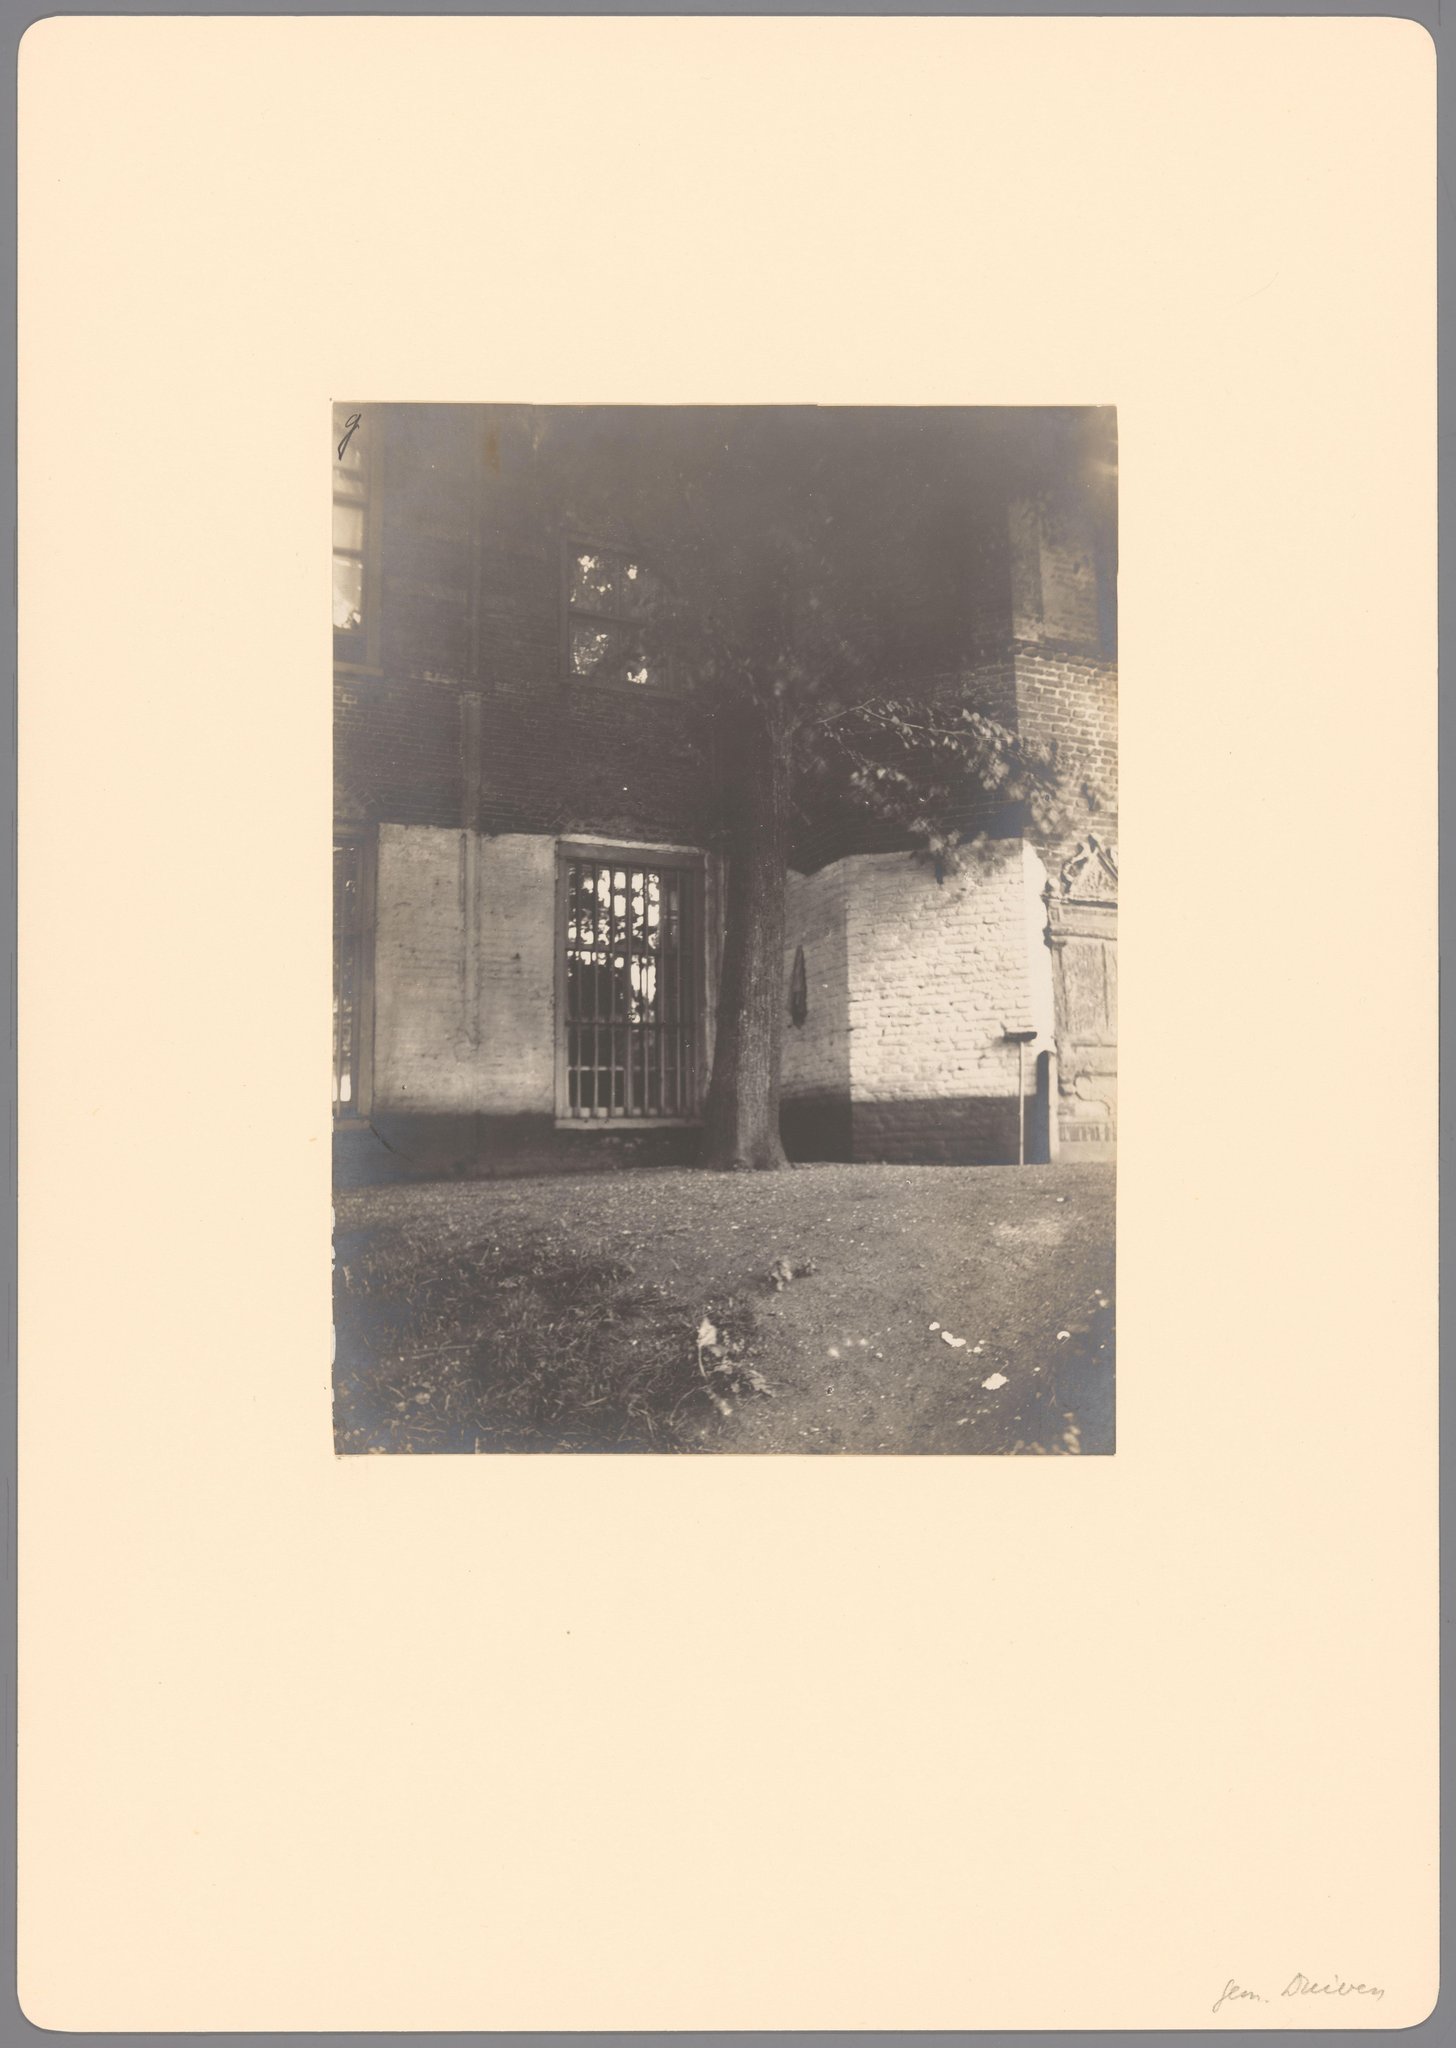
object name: photograph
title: Gedeelte van het Huis Loowaard te Duiven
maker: anoniem (monumentenzorg)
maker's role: fotograaf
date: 1907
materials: cardboard, photographic support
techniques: gelatin silver print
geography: duiven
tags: castle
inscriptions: annotation: ‘g/ gem. Duiven’, annotation: ‘Huize het Loo te (G.) Loowaard bij Duiven/ Loo bij Duiven’